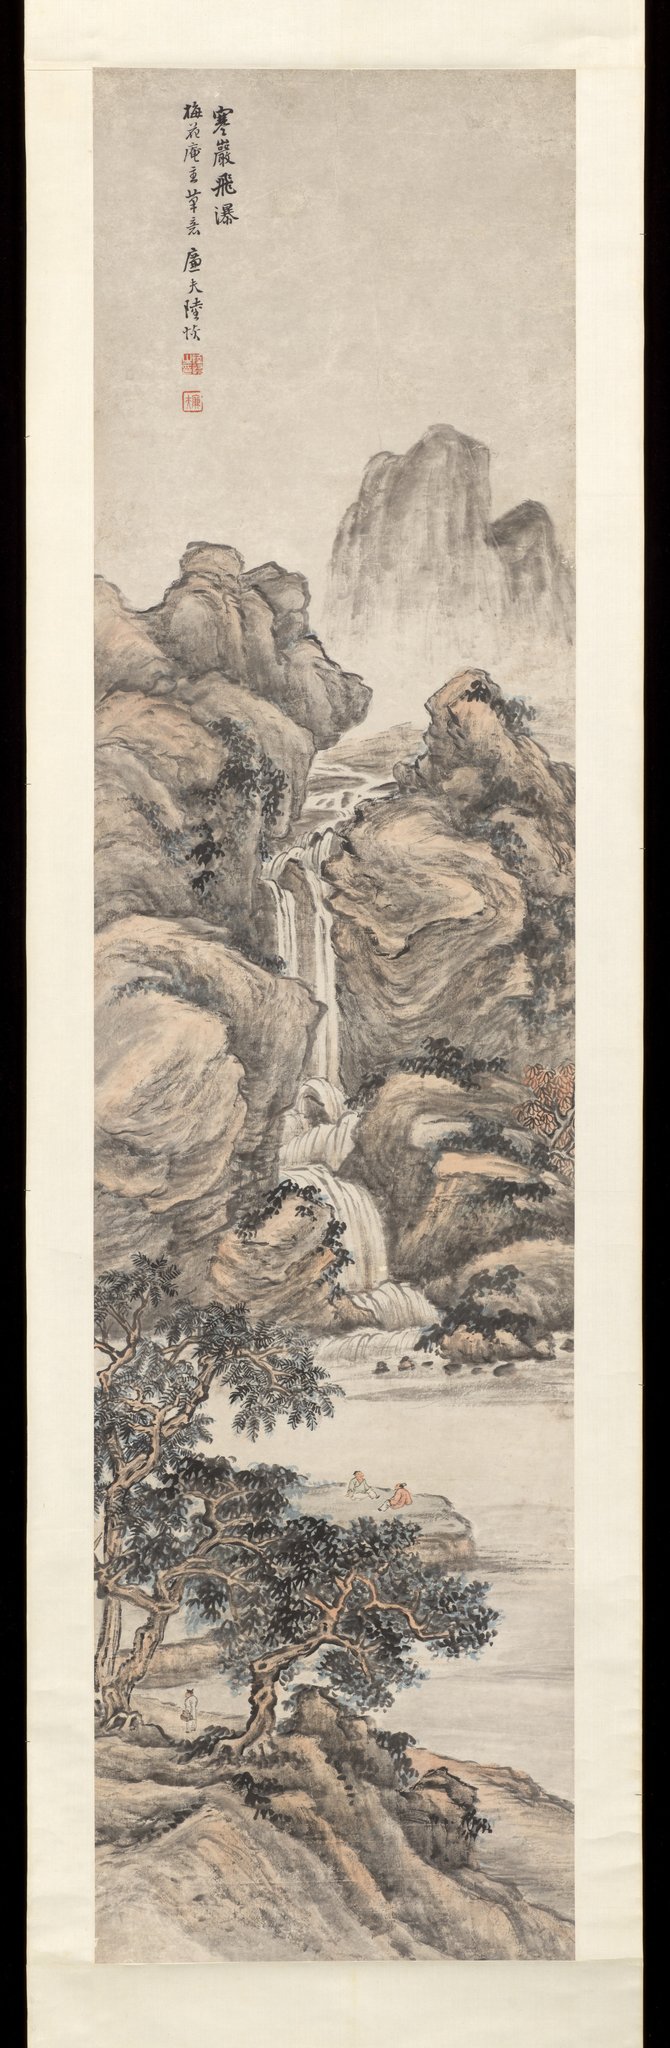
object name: hanging scroll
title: Waterfall on a Cold Cliff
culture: chinese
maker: lu hui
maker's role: artist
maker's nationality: chinese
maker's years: 1851-1920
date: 1851-1920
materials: ink, paper